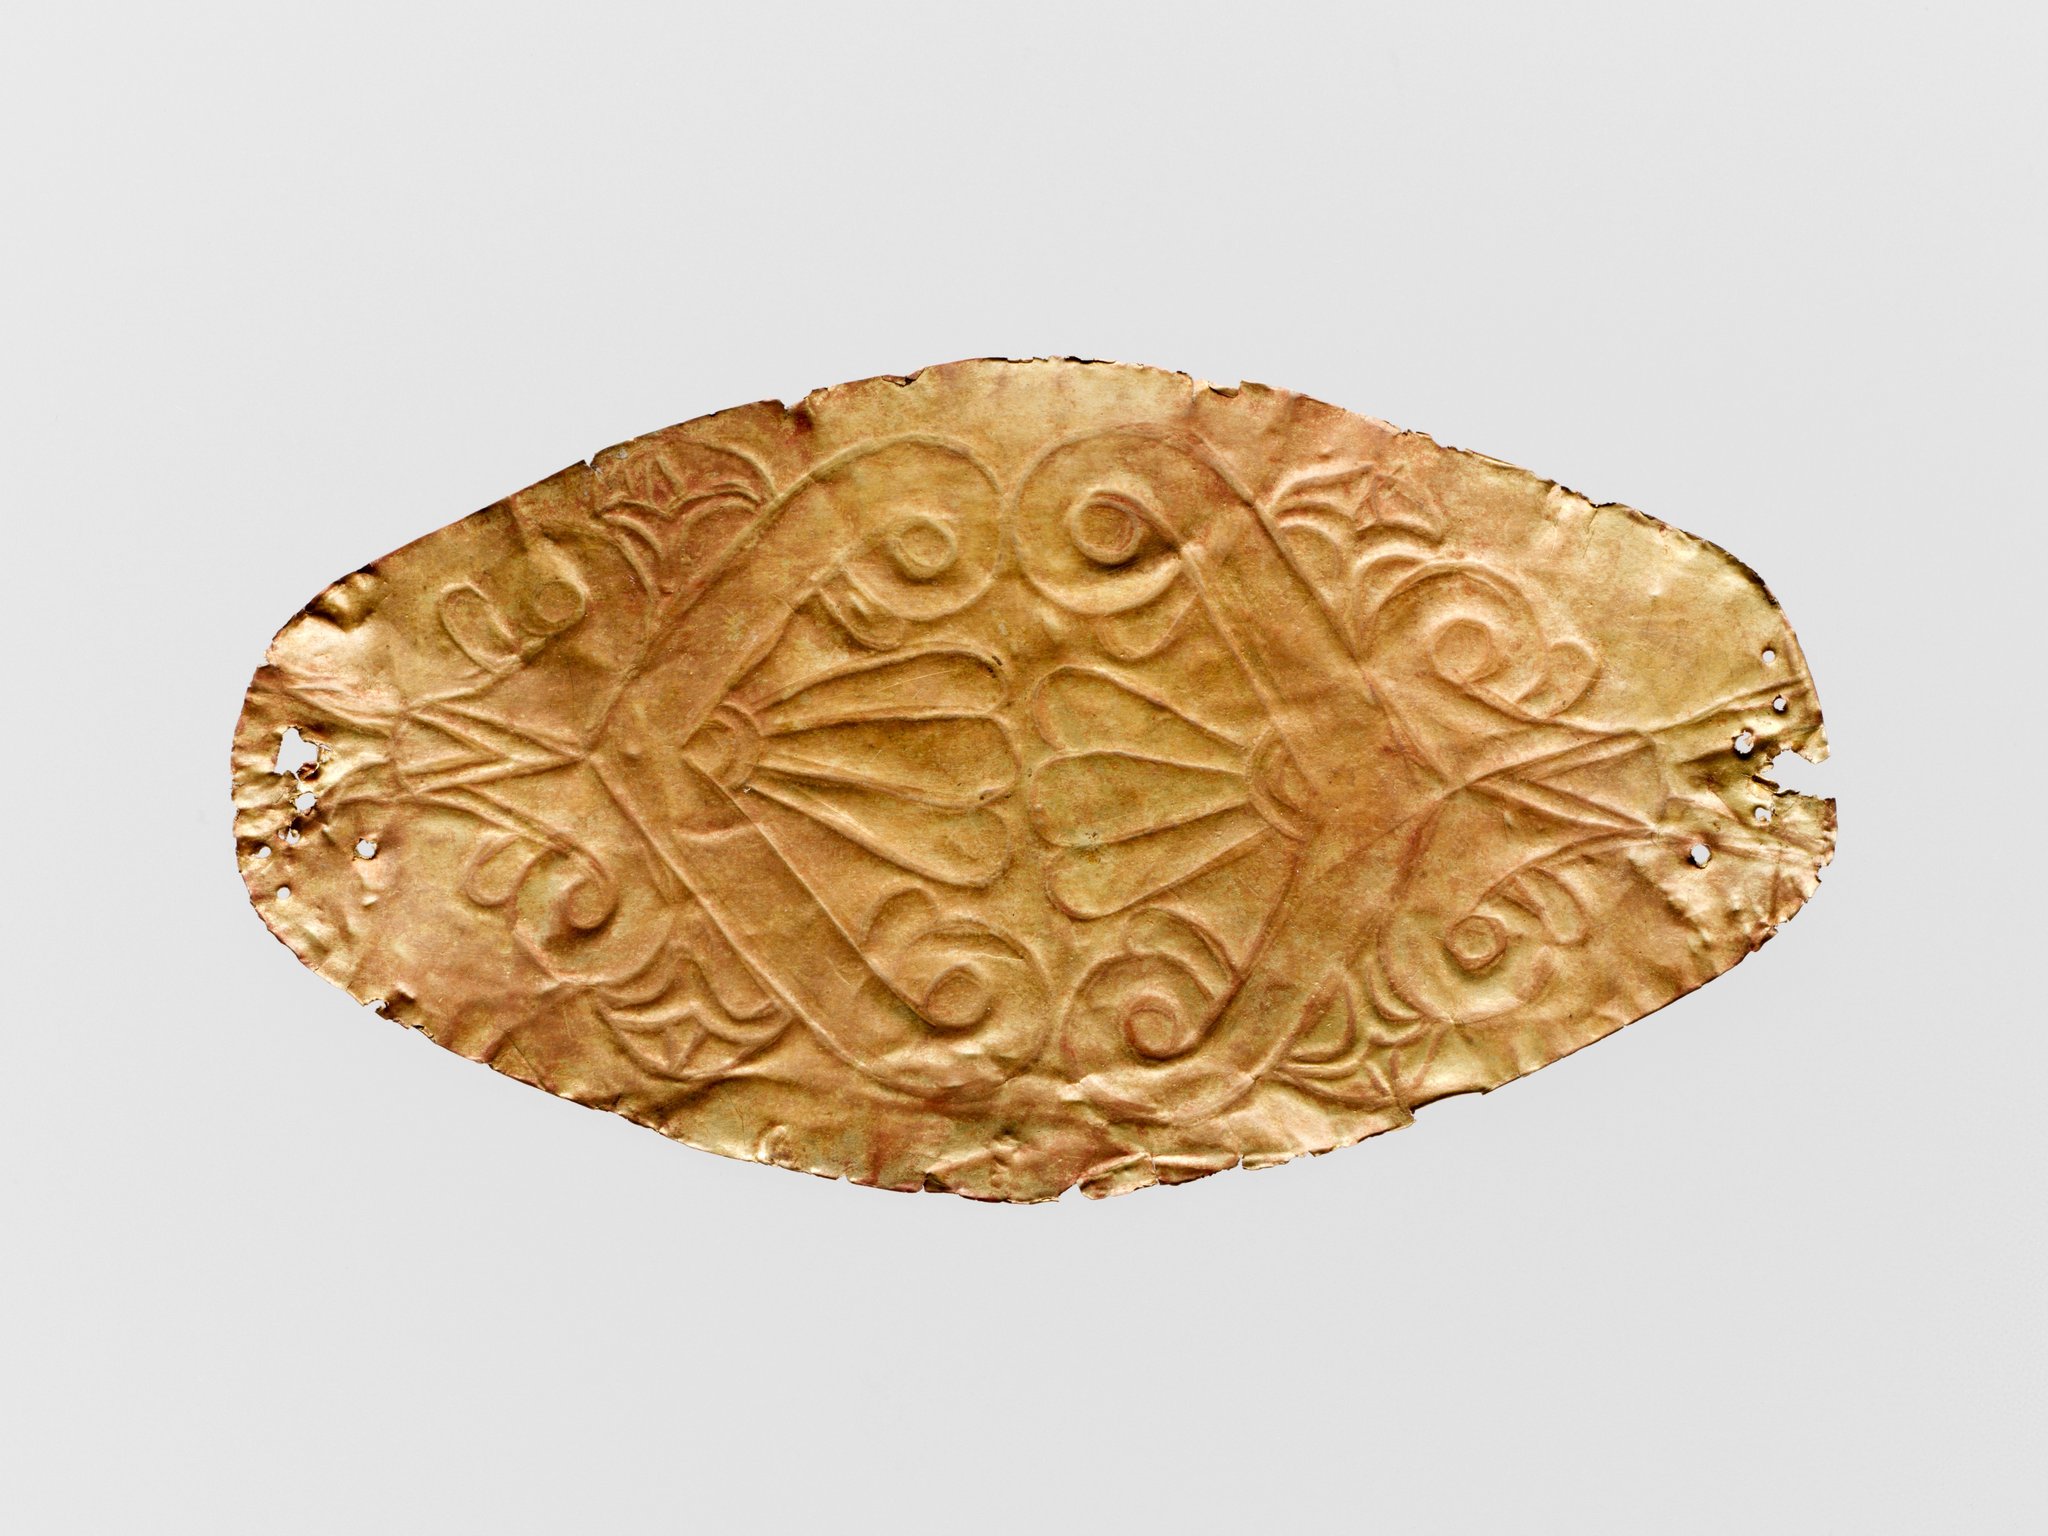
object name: mouth plate or frontlet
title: Gold leaf frontlet (band for forehead)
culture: cypriot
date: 700-501 BCE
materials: gold